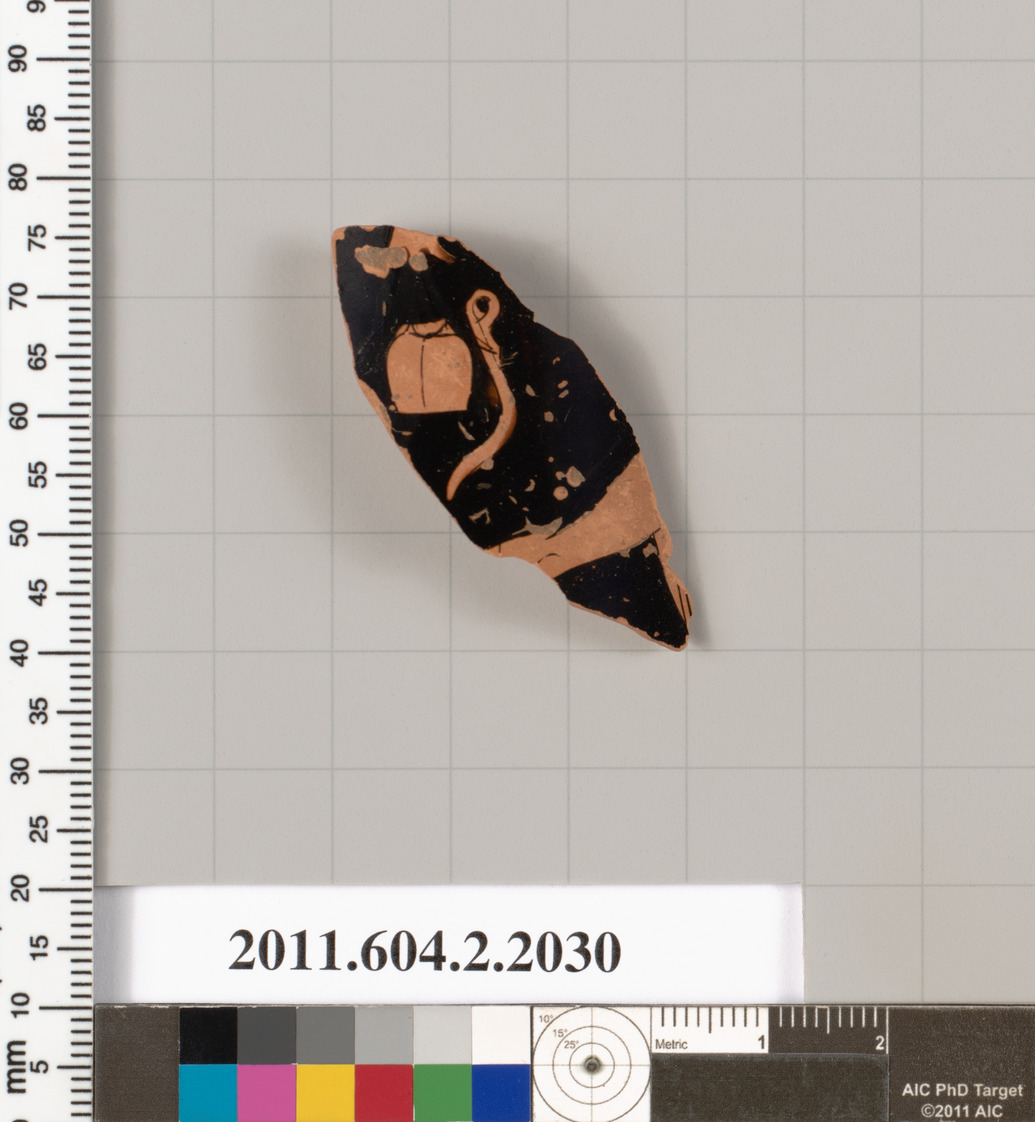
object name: alabastron fragment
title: Terracotta fragment of an alabastron (perfume vase)?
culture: greek, attic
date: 480-470 BCE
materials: terracotta